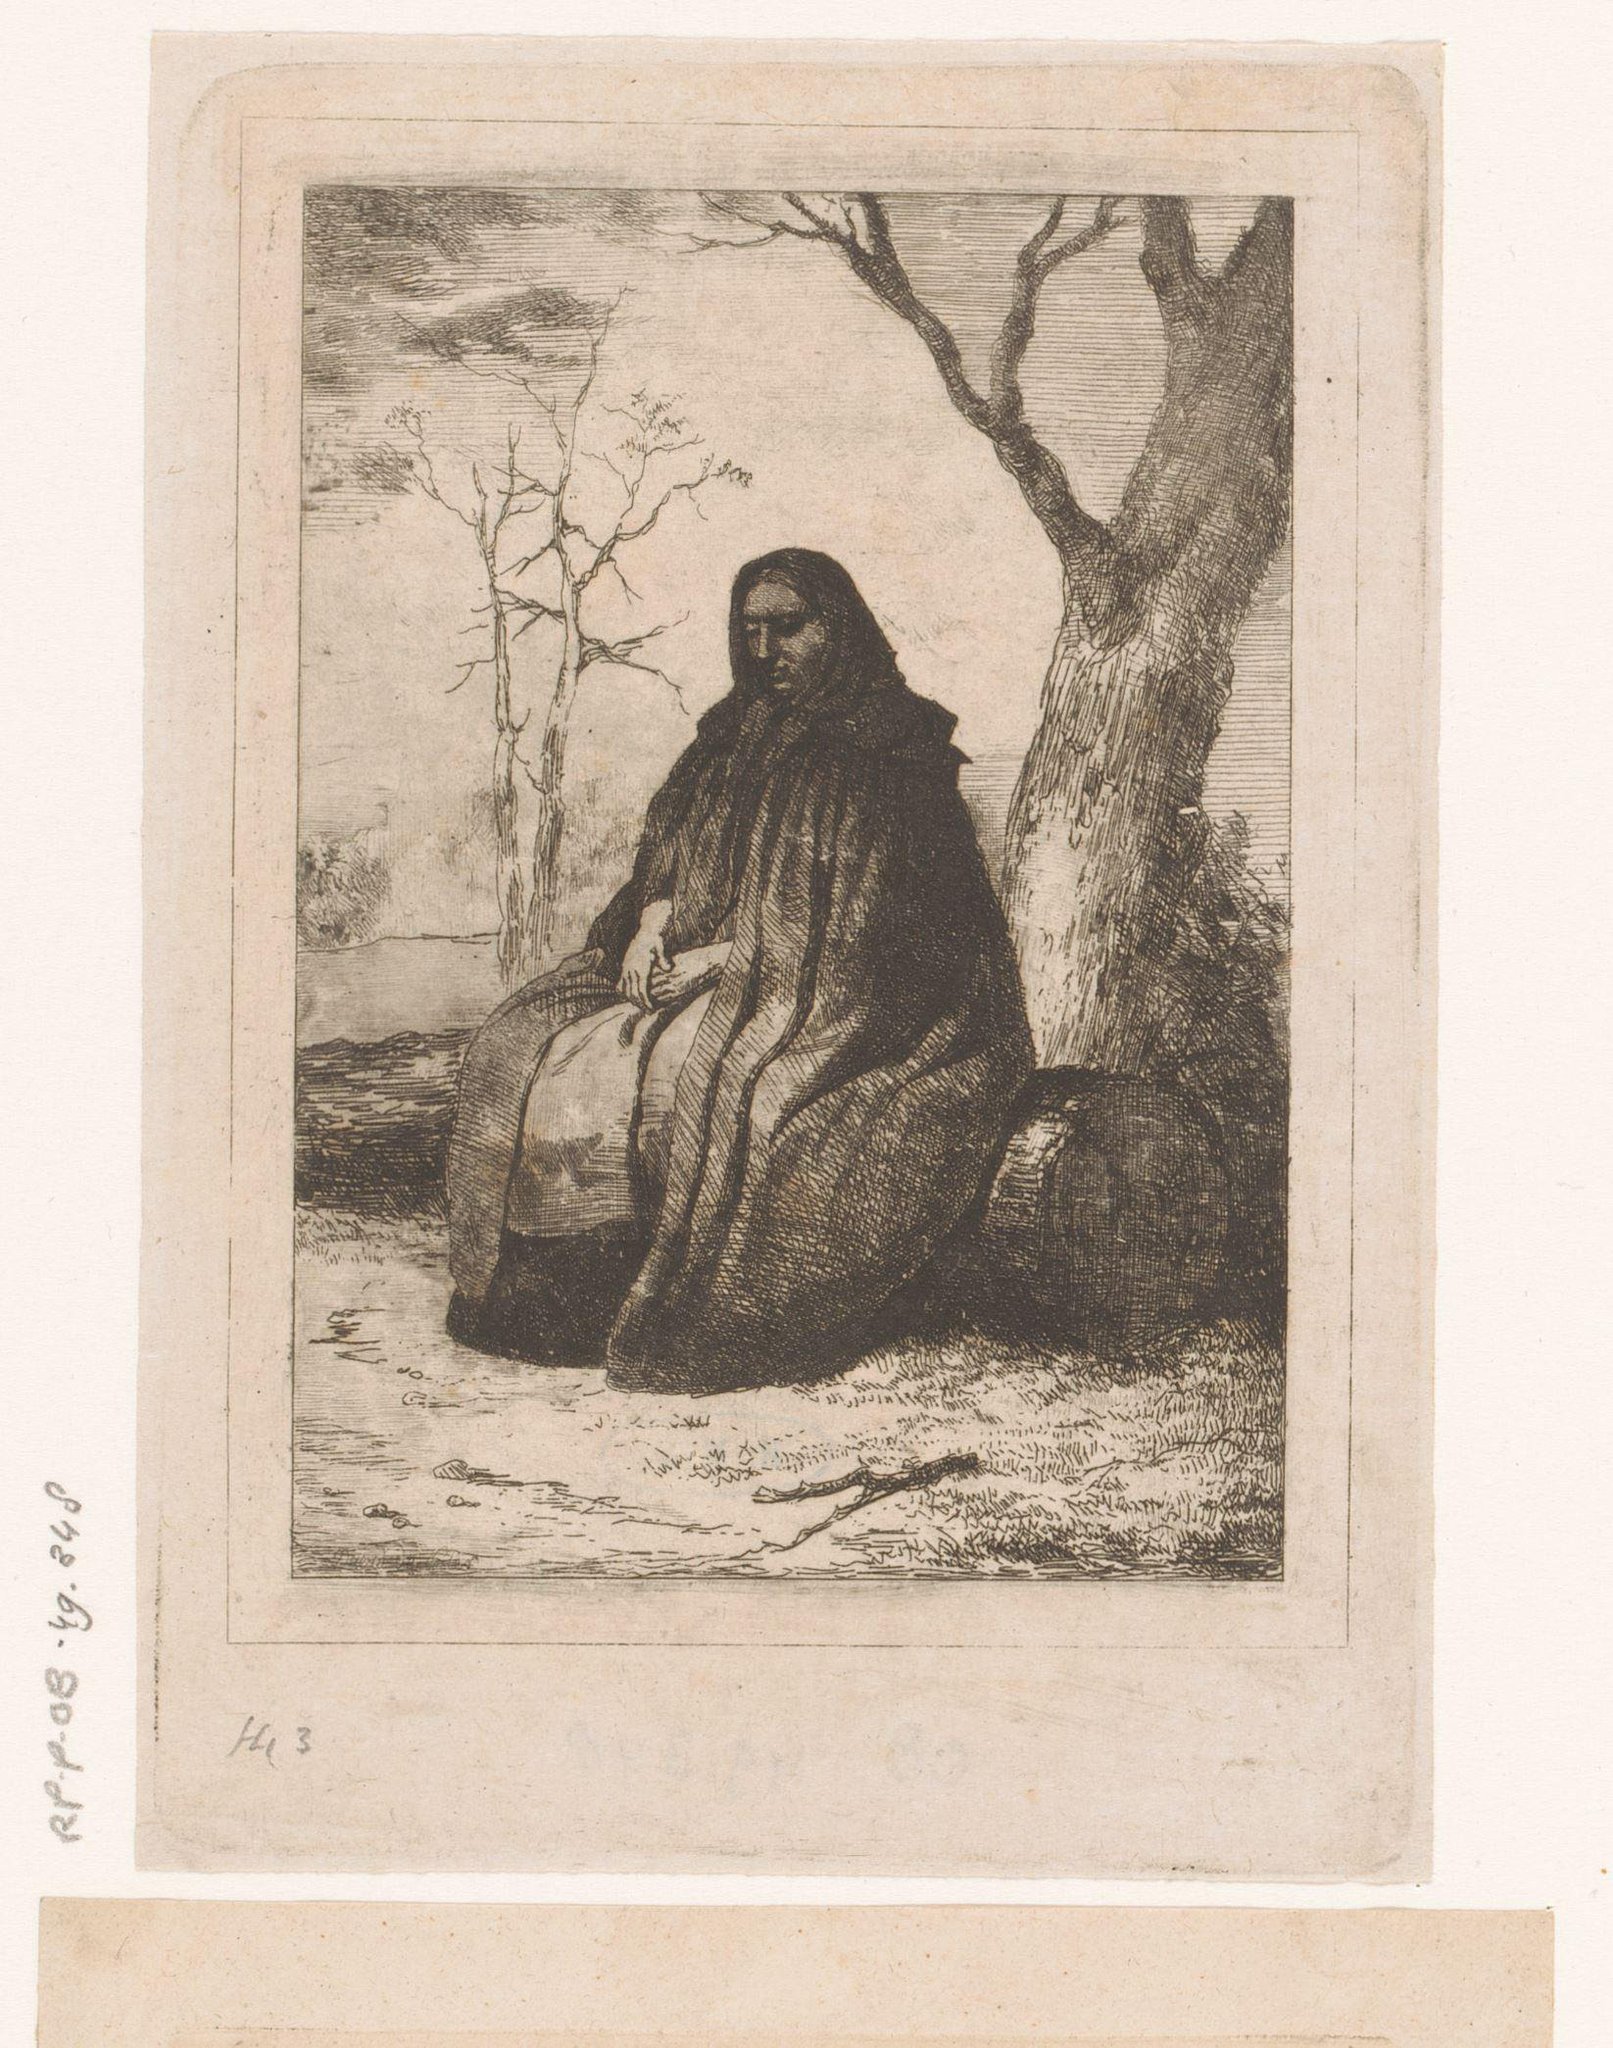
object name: print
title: Vrouw gezeten op een boomstam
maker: david emile joseph de noter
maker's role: painter, print maker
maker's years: 1818-1892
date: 1828-1879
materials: paper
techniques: etching, intaglio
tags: trees, adult woman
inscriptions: collector's mark: Lugt 2228